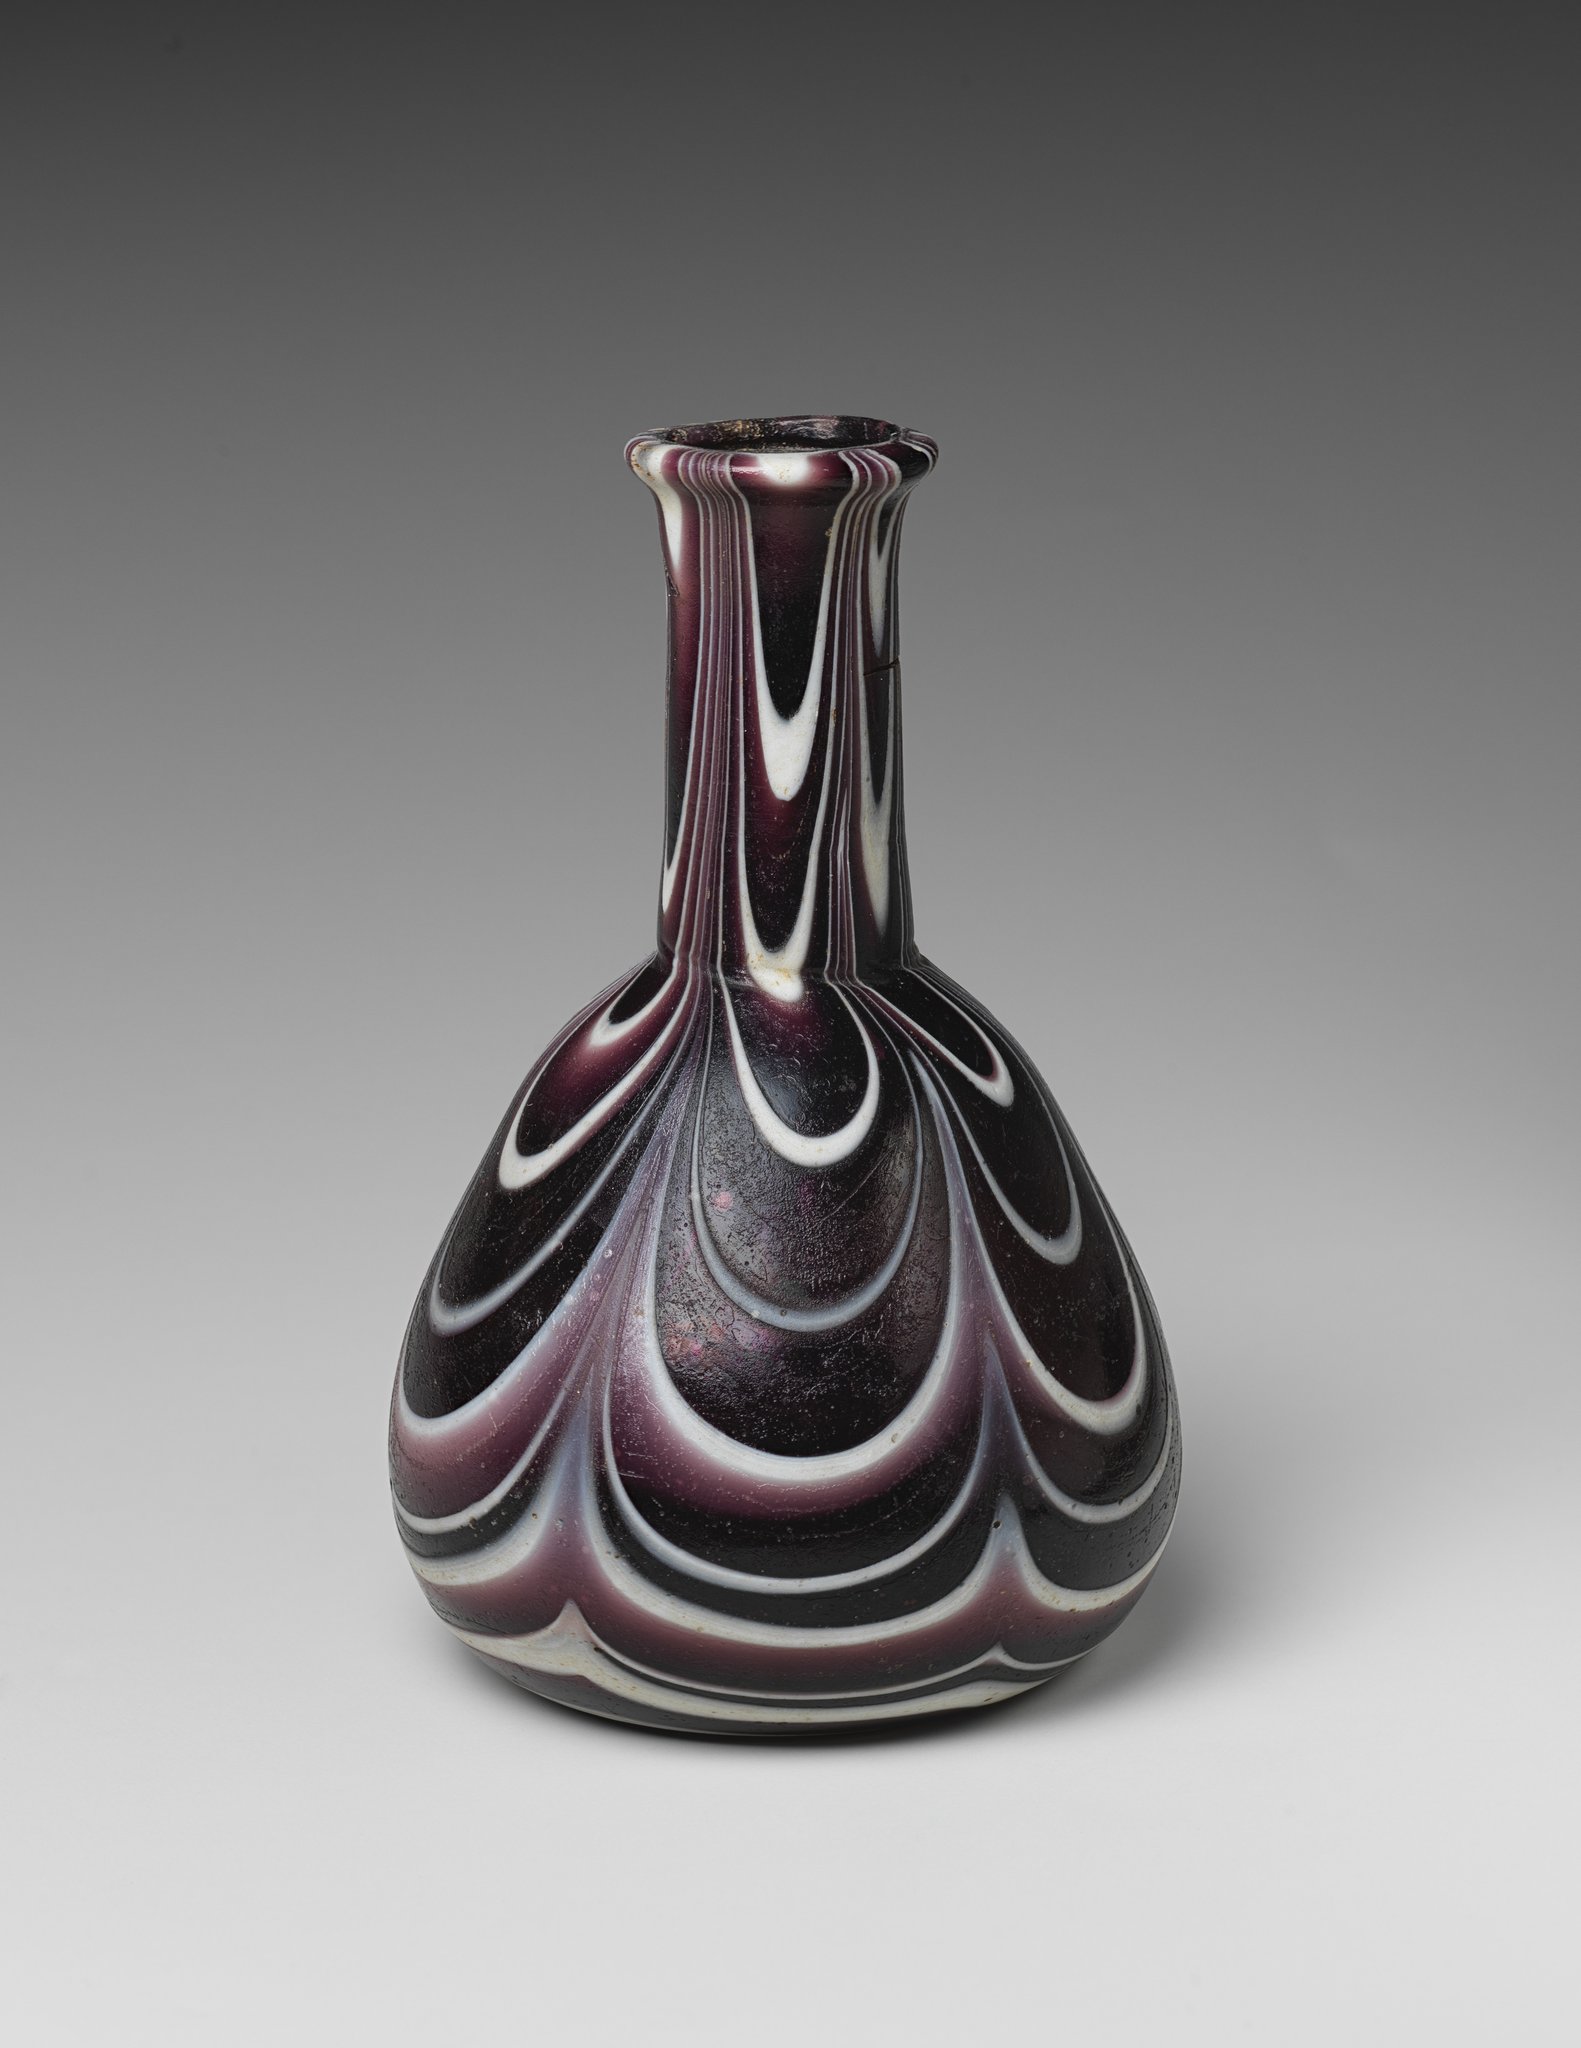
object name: bottle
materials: glass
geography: egypt